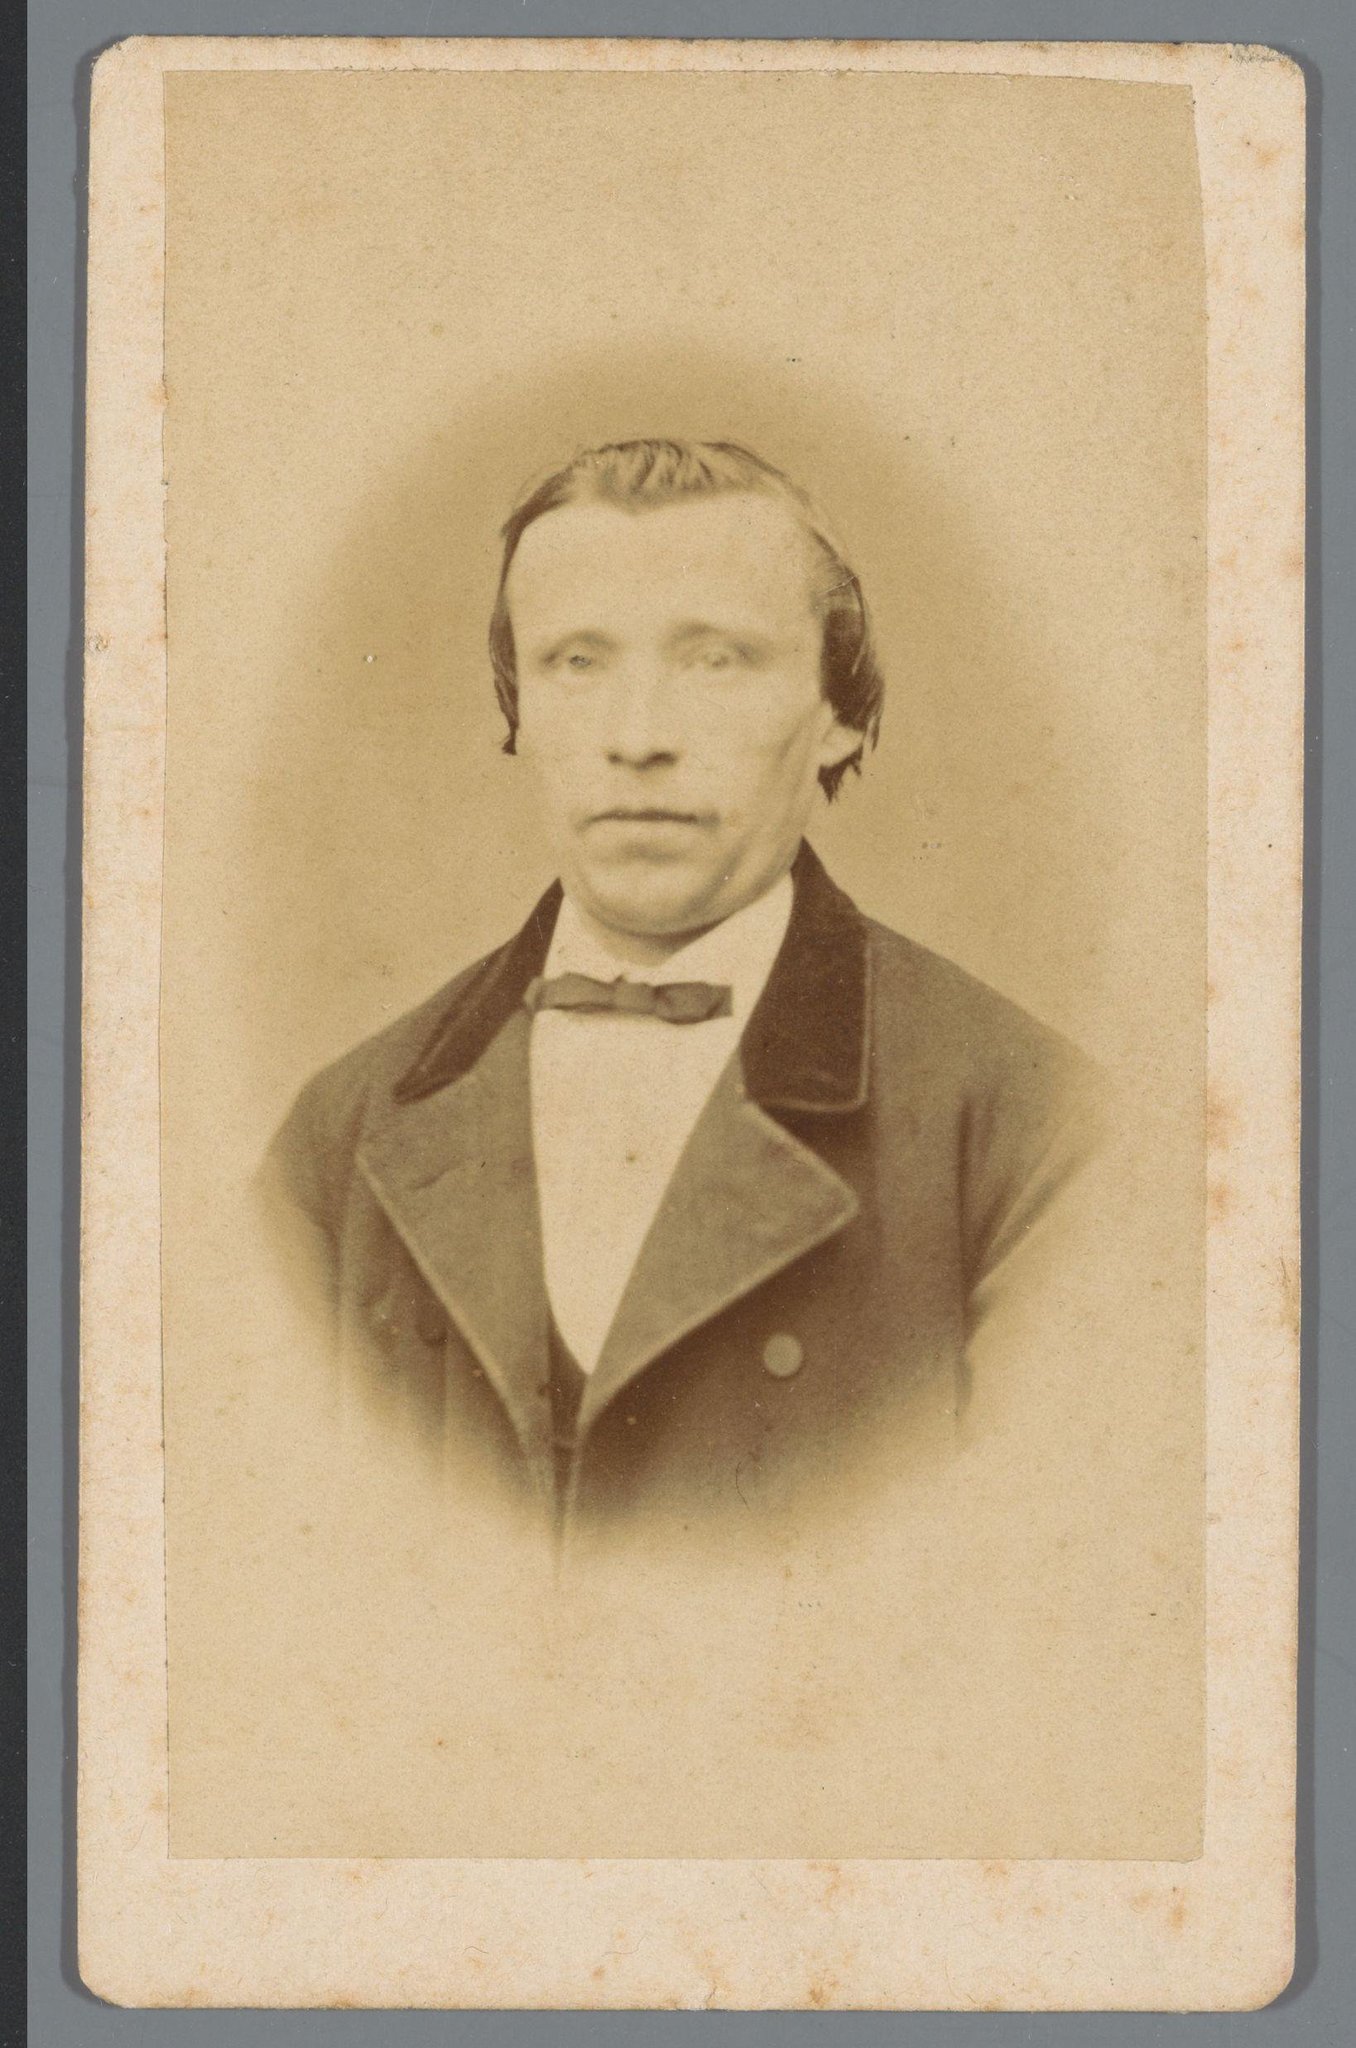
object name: carte de visite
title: Portret van een onbekende man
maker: bernardus petrus rabels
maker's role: fotograaf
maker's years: 1824-1906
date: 1870-1893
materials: cardboard, paper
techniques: albumen print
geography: amsterdam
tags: adult man, anonymous historical person portrayed, amsterdam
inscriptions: inscription: ‘Photographisch Atelier/ van/ B.P. Rabels/ Prinsengracht bij de Leliestraat M.M.138./ Amsterdam.’